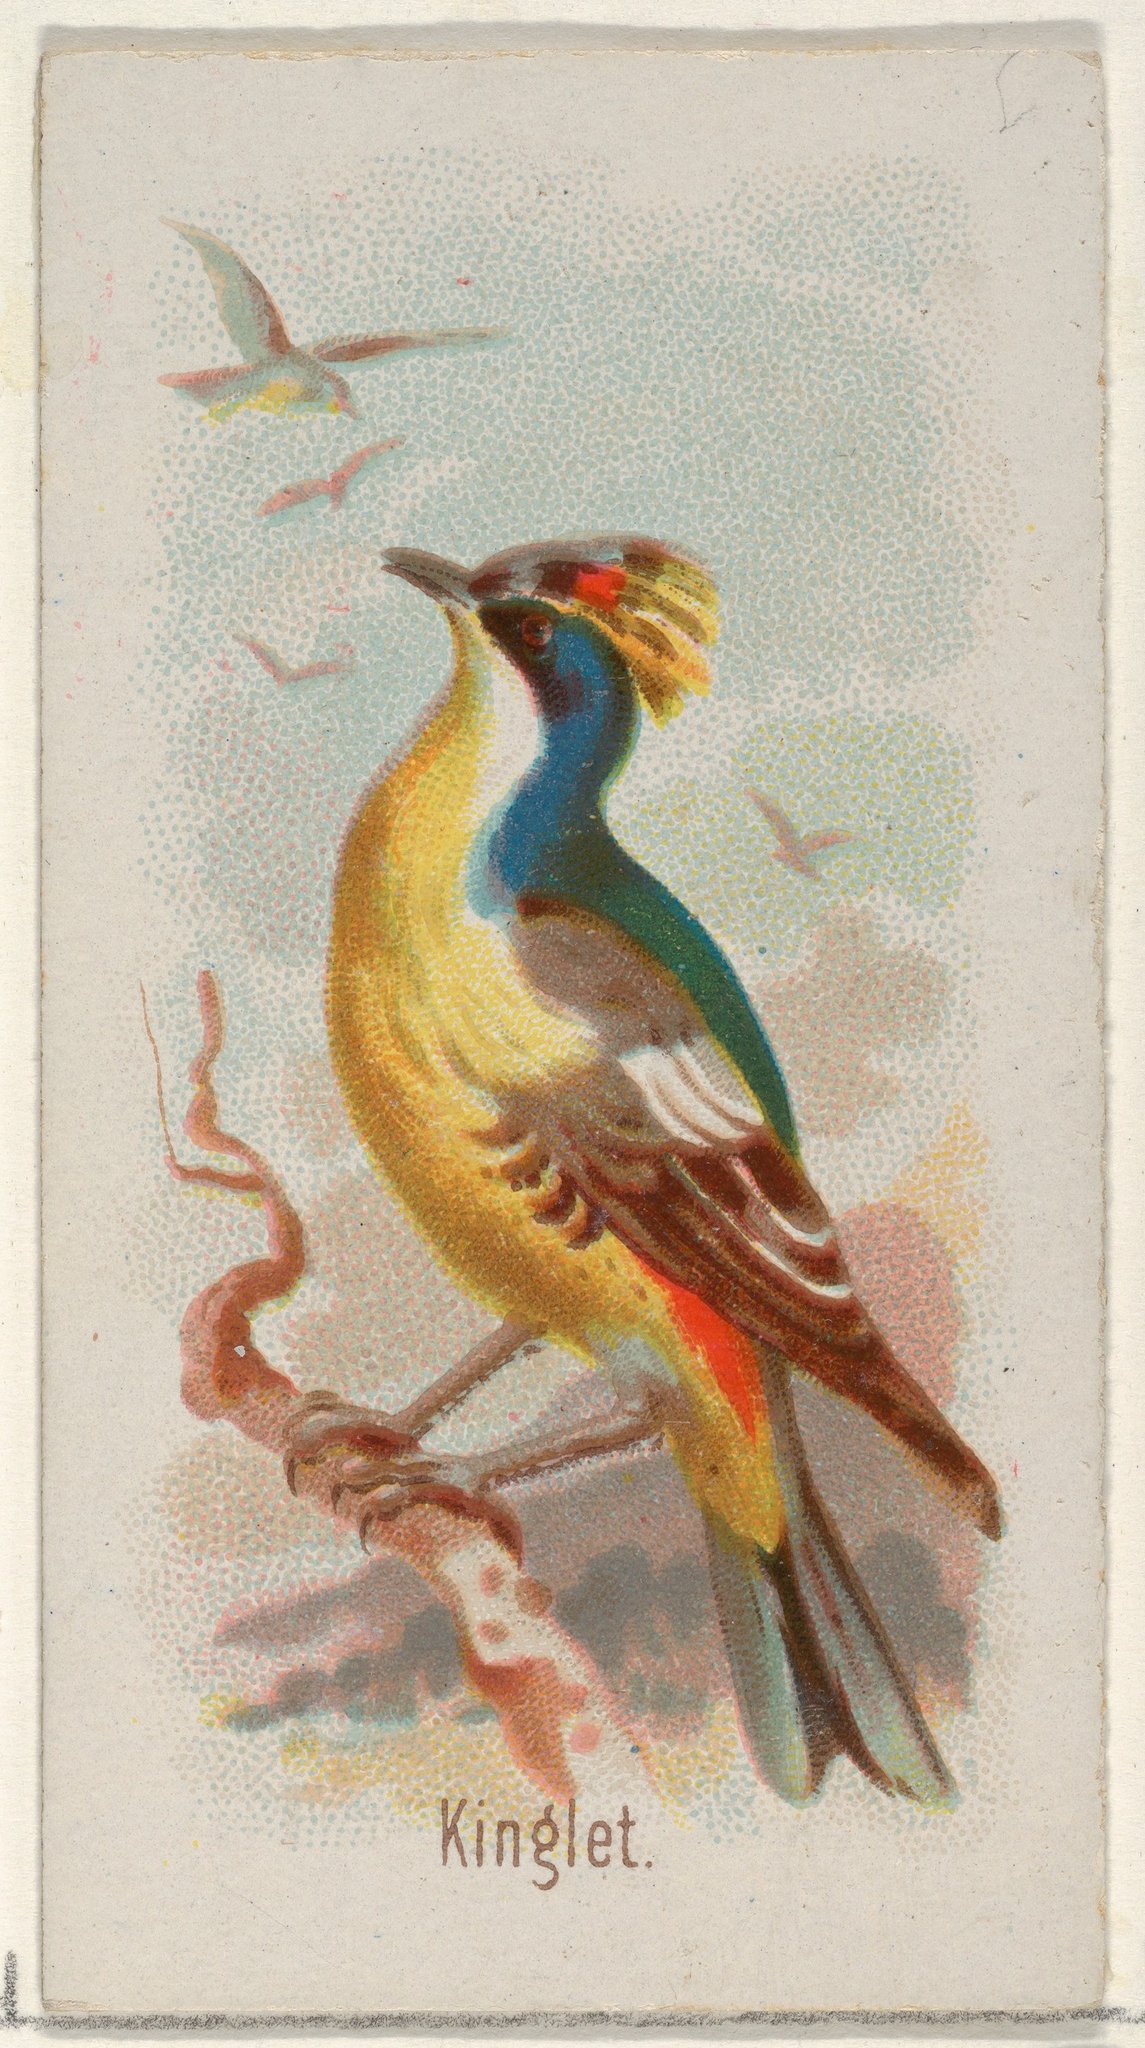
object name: print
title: Kinglet, from the Song Birds of the World series (N23) for Allen & Ginter Cigarettes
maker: allen & ginter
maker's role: publisher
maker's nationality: american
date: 1890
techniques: color lithograph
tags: birds